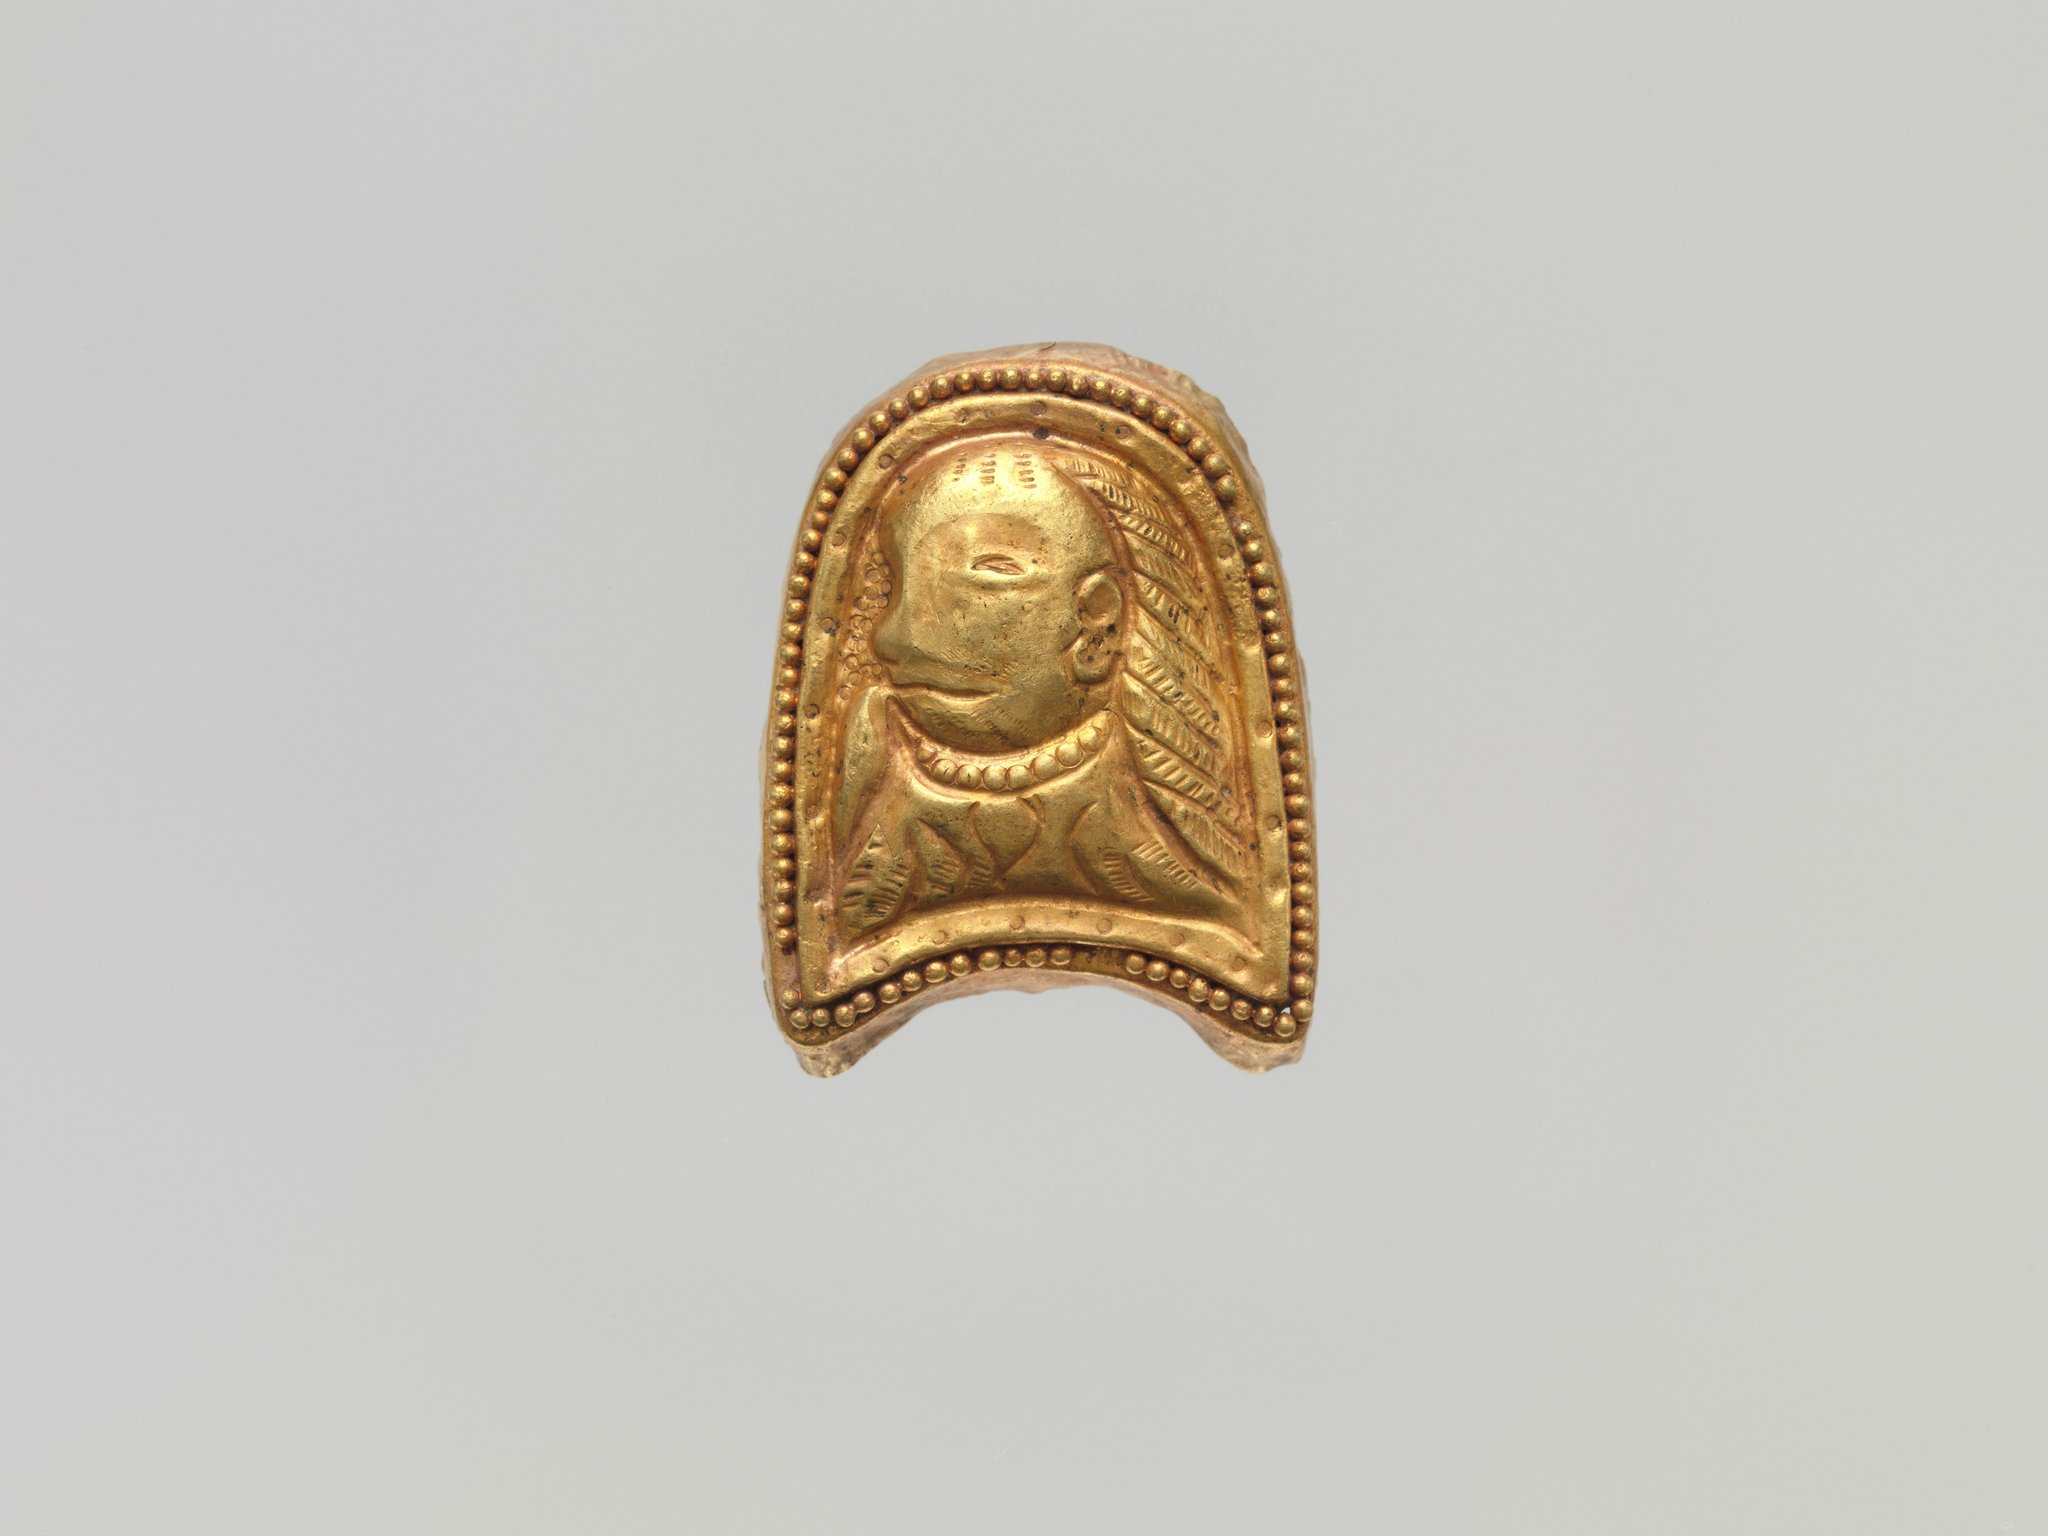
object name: plaque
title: Plaque with Head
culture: chinese or central asian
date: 601-900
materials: gold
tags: heads